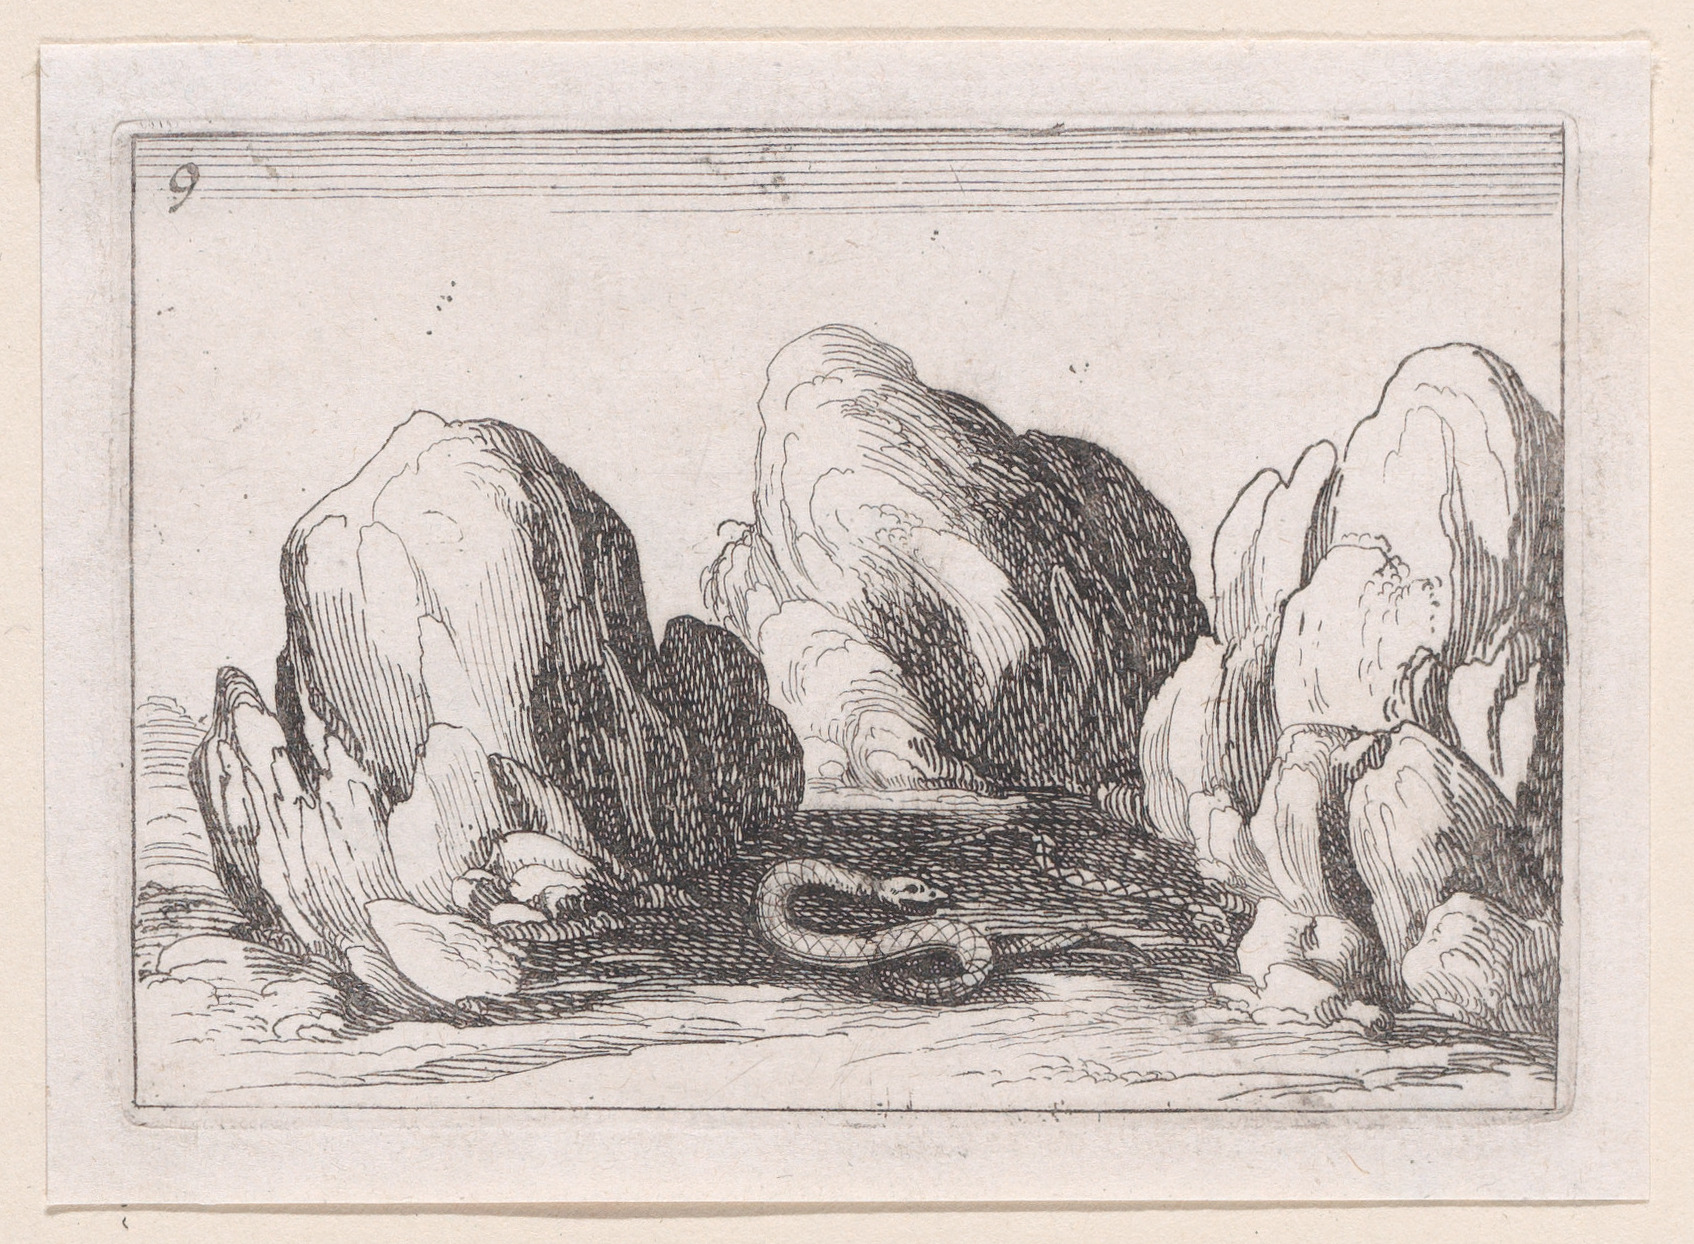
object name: print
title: Le Serpent (The Serpent), plate 9 from "Lux Claustri ou La Lumière du Cloitre" (The Light of the Cloisters)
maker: jacques callot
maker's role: artist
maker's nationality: french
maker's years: 1592-1635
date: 1621-1635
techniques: etching